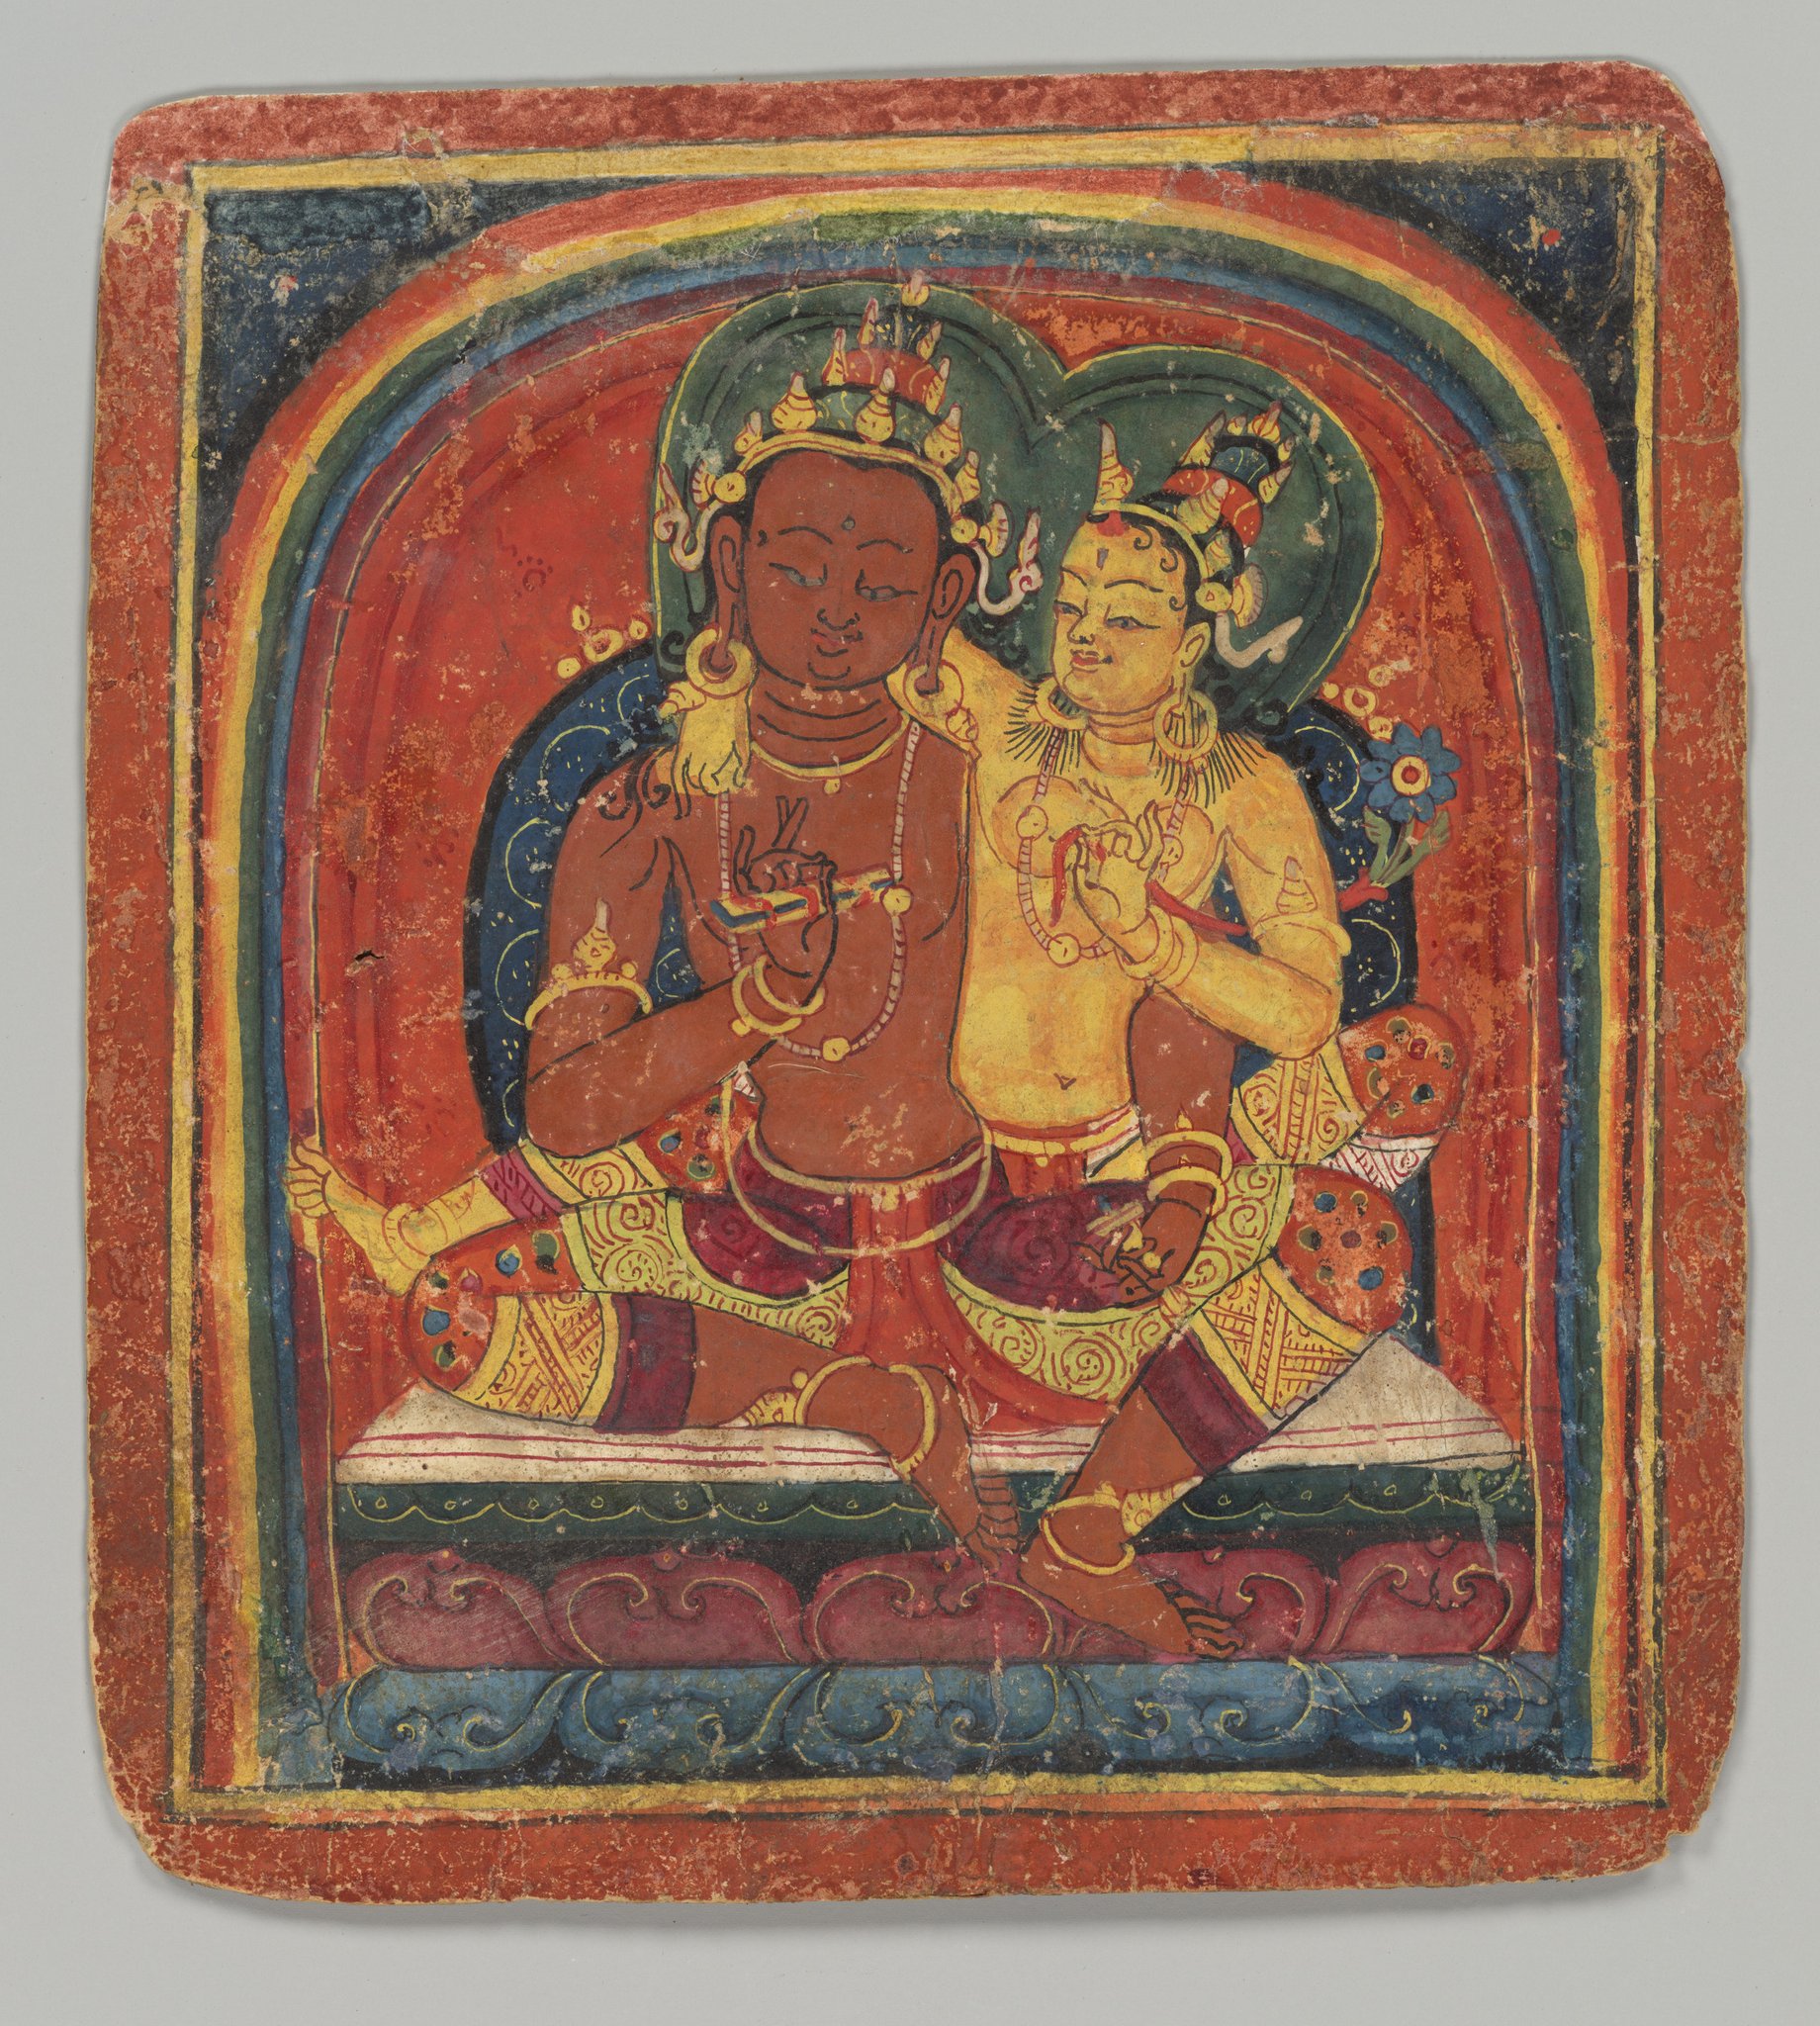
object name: initiation card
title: Initiation Card (Tsakalis): Nirvana Vishkambhin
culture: tibetan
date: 1401-1433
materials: paper, watercolor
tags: deities